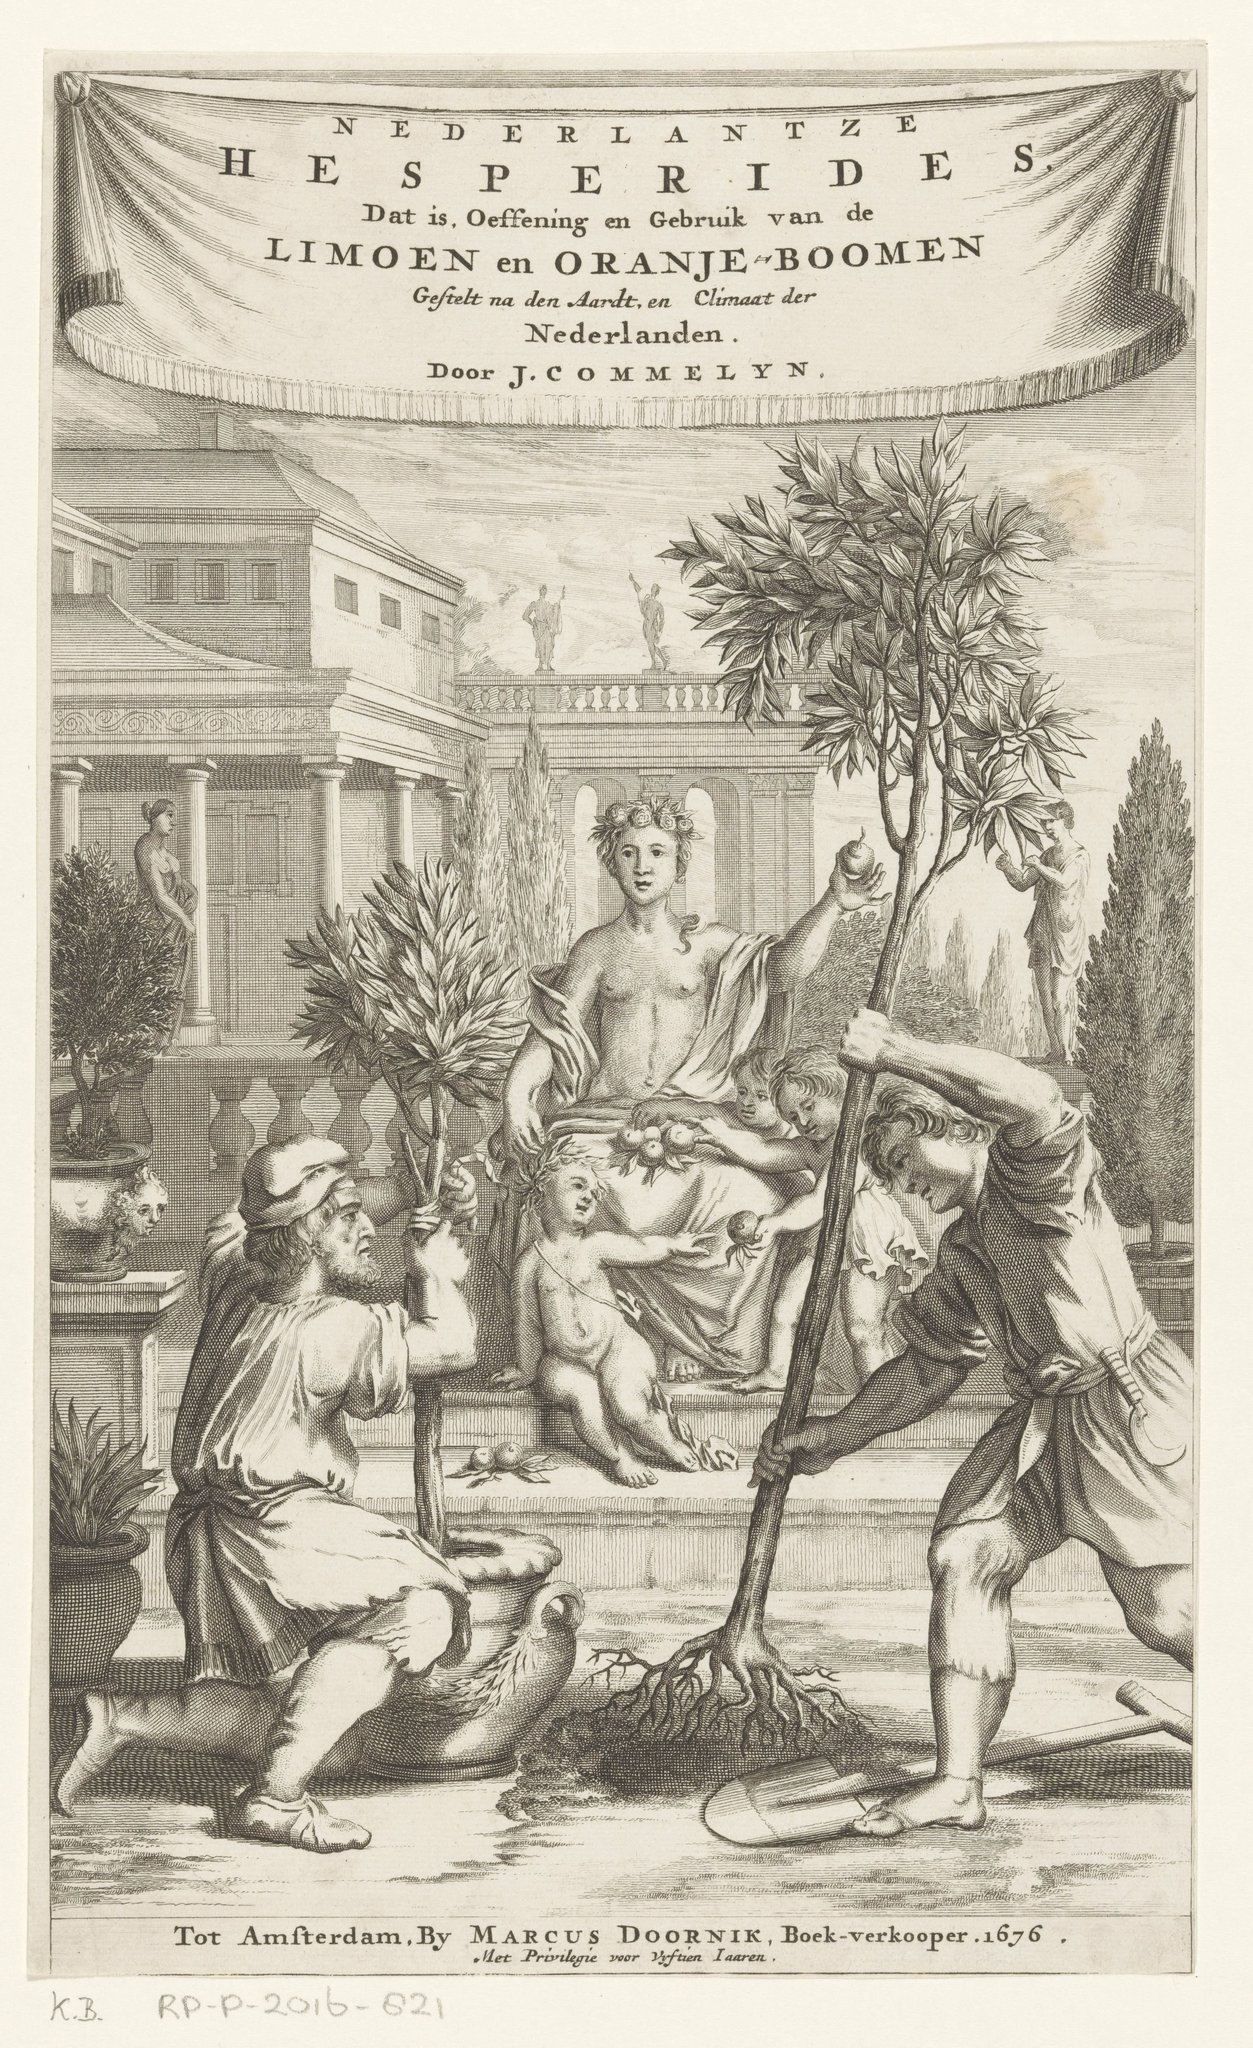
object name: print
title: Titelpagina voor: Isaak Commelin, Nederlantze Hesperides, Dat is, Oeggening en Gebruik van de Limoen en Oranje-Boomen Gestelt na den Aardt, en Climaat der Nederlanden, 1676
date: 1676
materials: paper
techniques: engraving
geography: amsterdam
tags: fruit-tree culture; fruit harvest, gardening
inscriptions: collector's mark: Lugt 240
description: Titelpagina voor: Commelin, Isaak. Nederlantze Hesperides, Dat is, Oeggening en Gebruik van de Limoen en Oranje-Boomen Gestelt na den Aardt, en Climaat der Nederlanden. Amsterdam: Doornick, Marcus Willemsz., 1676.